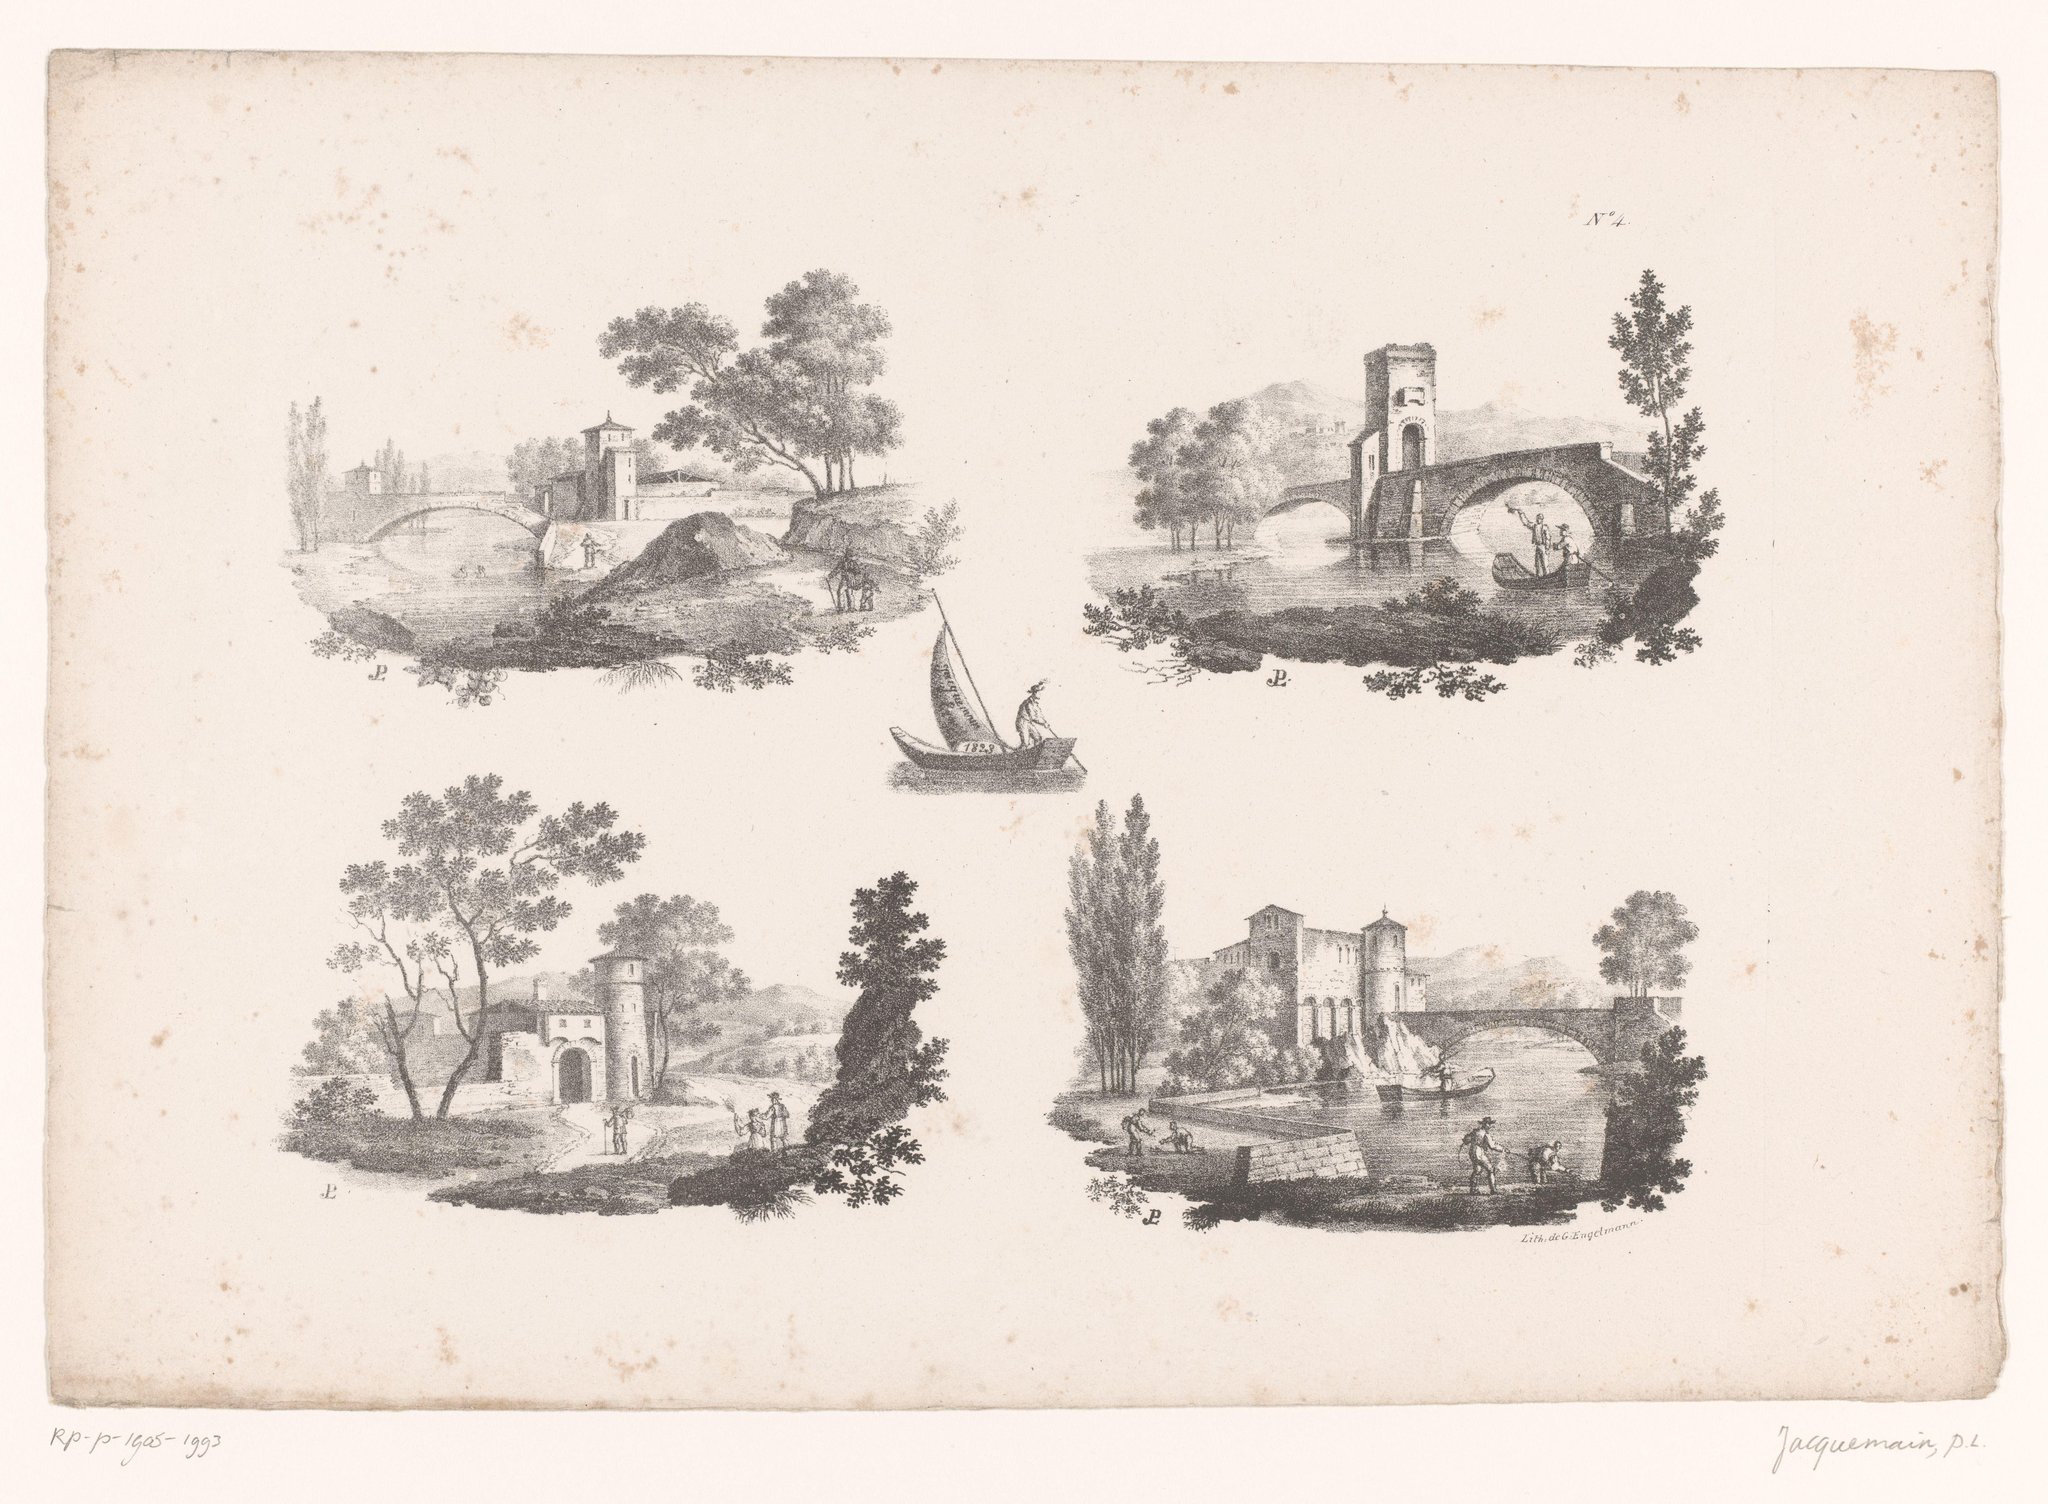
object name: print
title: Vier voorstellingen van bruggen en gebouwen in een landschap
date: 1823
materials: paper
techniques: lithograph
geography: lyon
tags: village-gate (+ city(-scape) with figures, staffage), rowing-boat, canoe, etc., landscape with bridge, viaduct or aqueduct (+ city(-scape) with figures, staffage)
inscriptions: collector's mark: Lugt 2228a